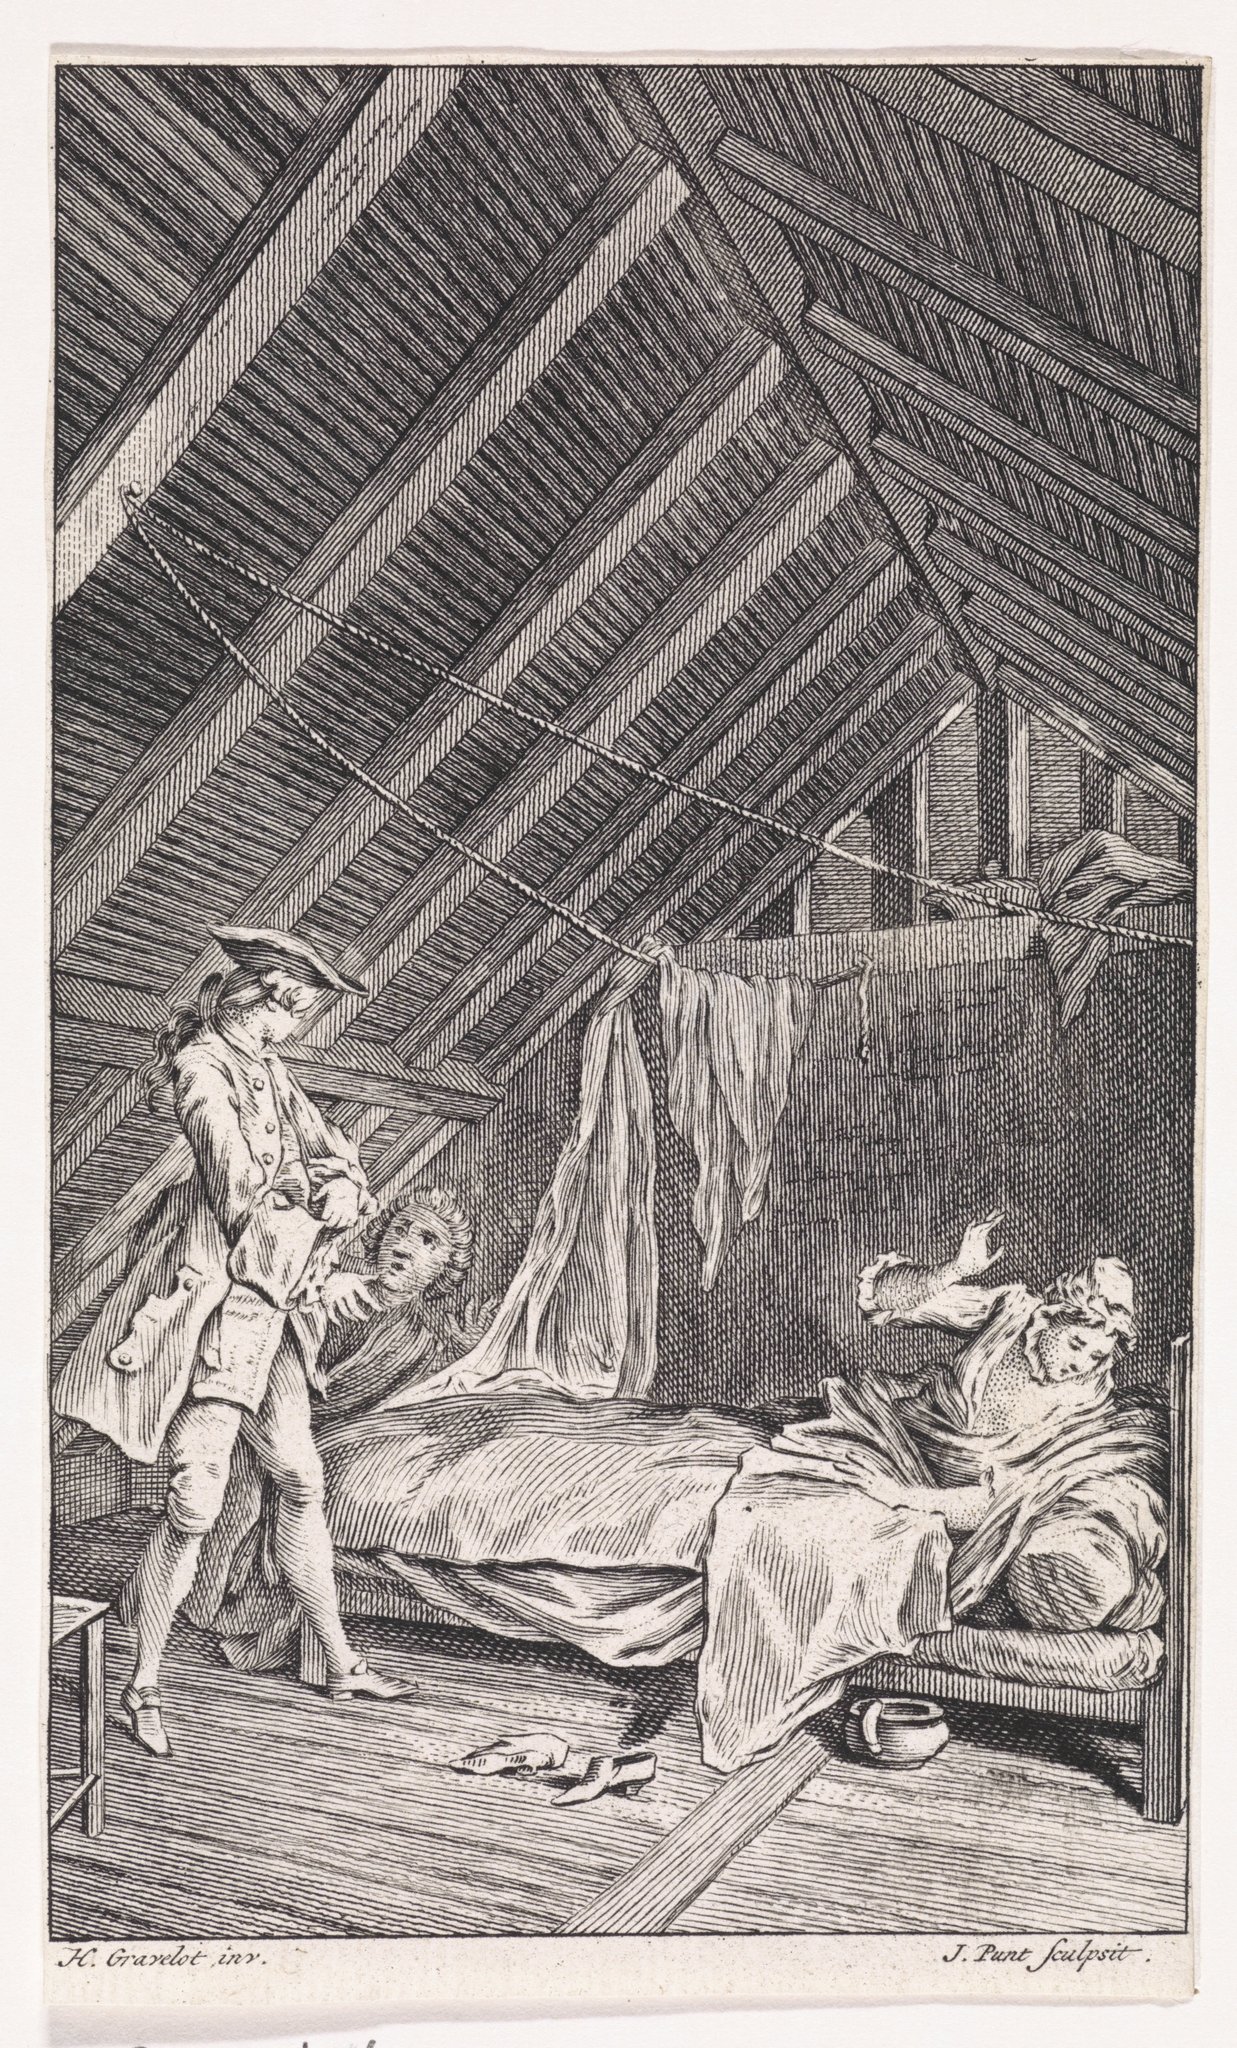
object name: print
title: Mietje en Thomas Jones op zolder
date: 1749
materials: paper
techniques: engraving, etching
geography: amsterdam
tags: attic, loft, specific works of literature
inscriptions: collector's mark: Lugt 2228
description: Prent gebruikt als illustratie in: Fielding, Henry. [Vertaald uit het Engels door] Pieter Le Clercq. Historie van den vondeling Tomas Jones, dl. 1, p. 355. Amsterdam: Gerrit de Groot, 1749.